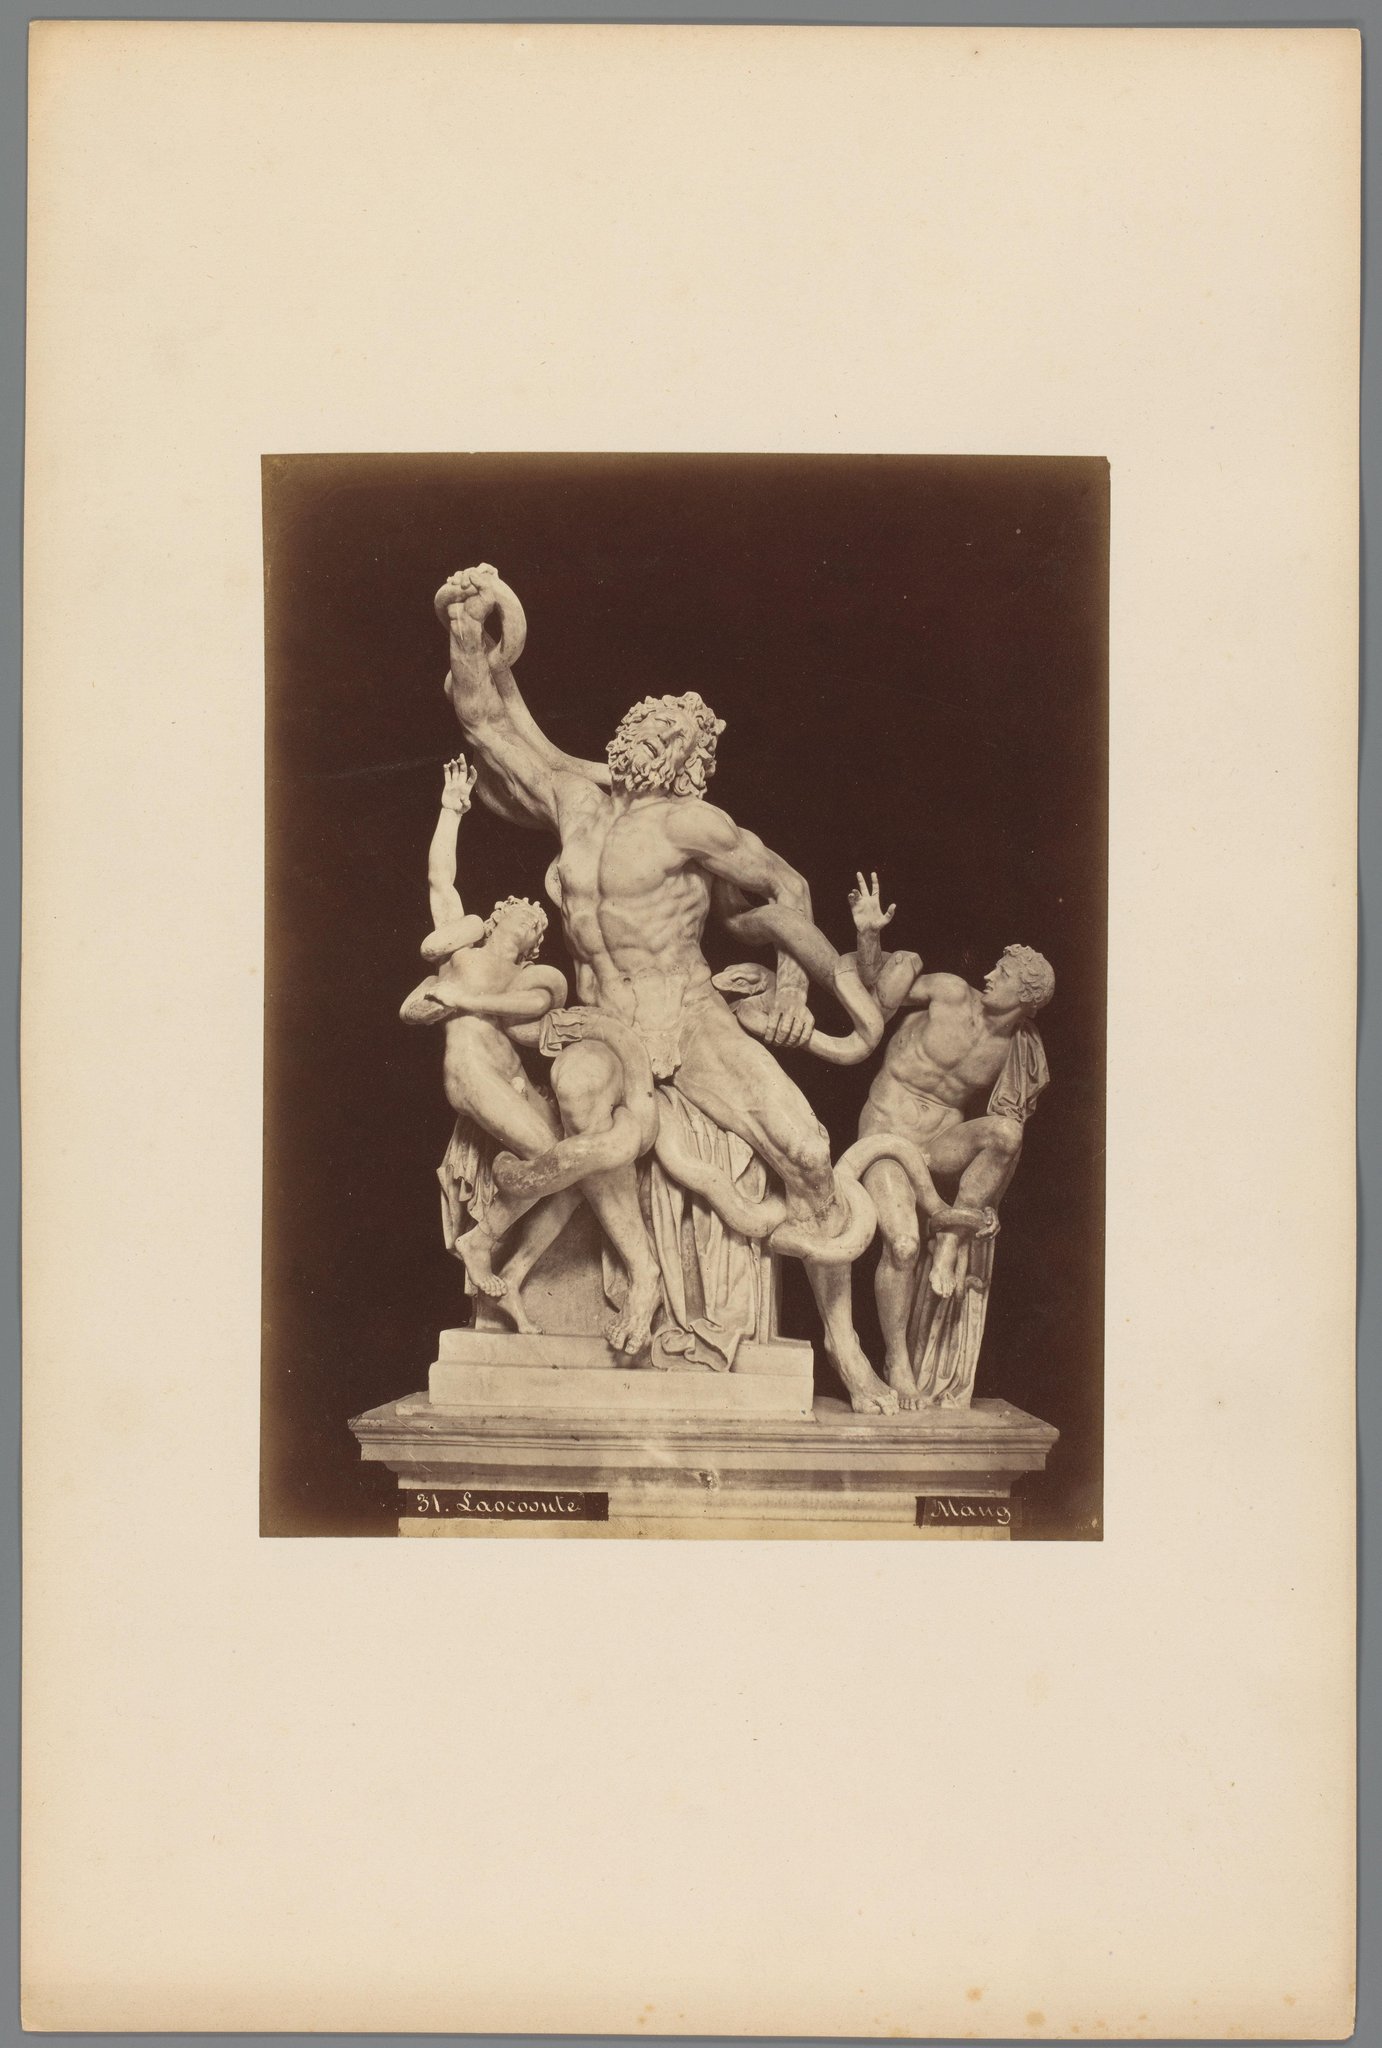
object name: photograph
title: Laocoonte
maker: michèle mang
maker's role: fotograaf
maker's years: 1840-1909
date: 1863-1887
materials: cardboard, paper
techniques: albumen print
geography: florence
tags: laocoon and his twin sons are strangled by two serpents during the preparations for a sacrifice, piece of sculpture, reproduction of a piece of sculpture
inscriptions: number: ‘31.’